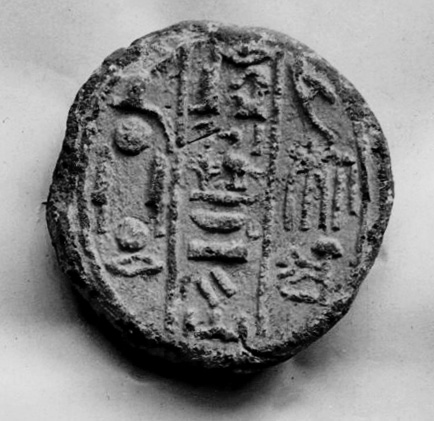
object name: cone, circular stamp, merymose, king's son, kush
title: Funerary Cone of the King's Son of Kush Merymose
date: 1550-1295 BCE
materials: pottery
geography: egypt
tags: hieroglyphs